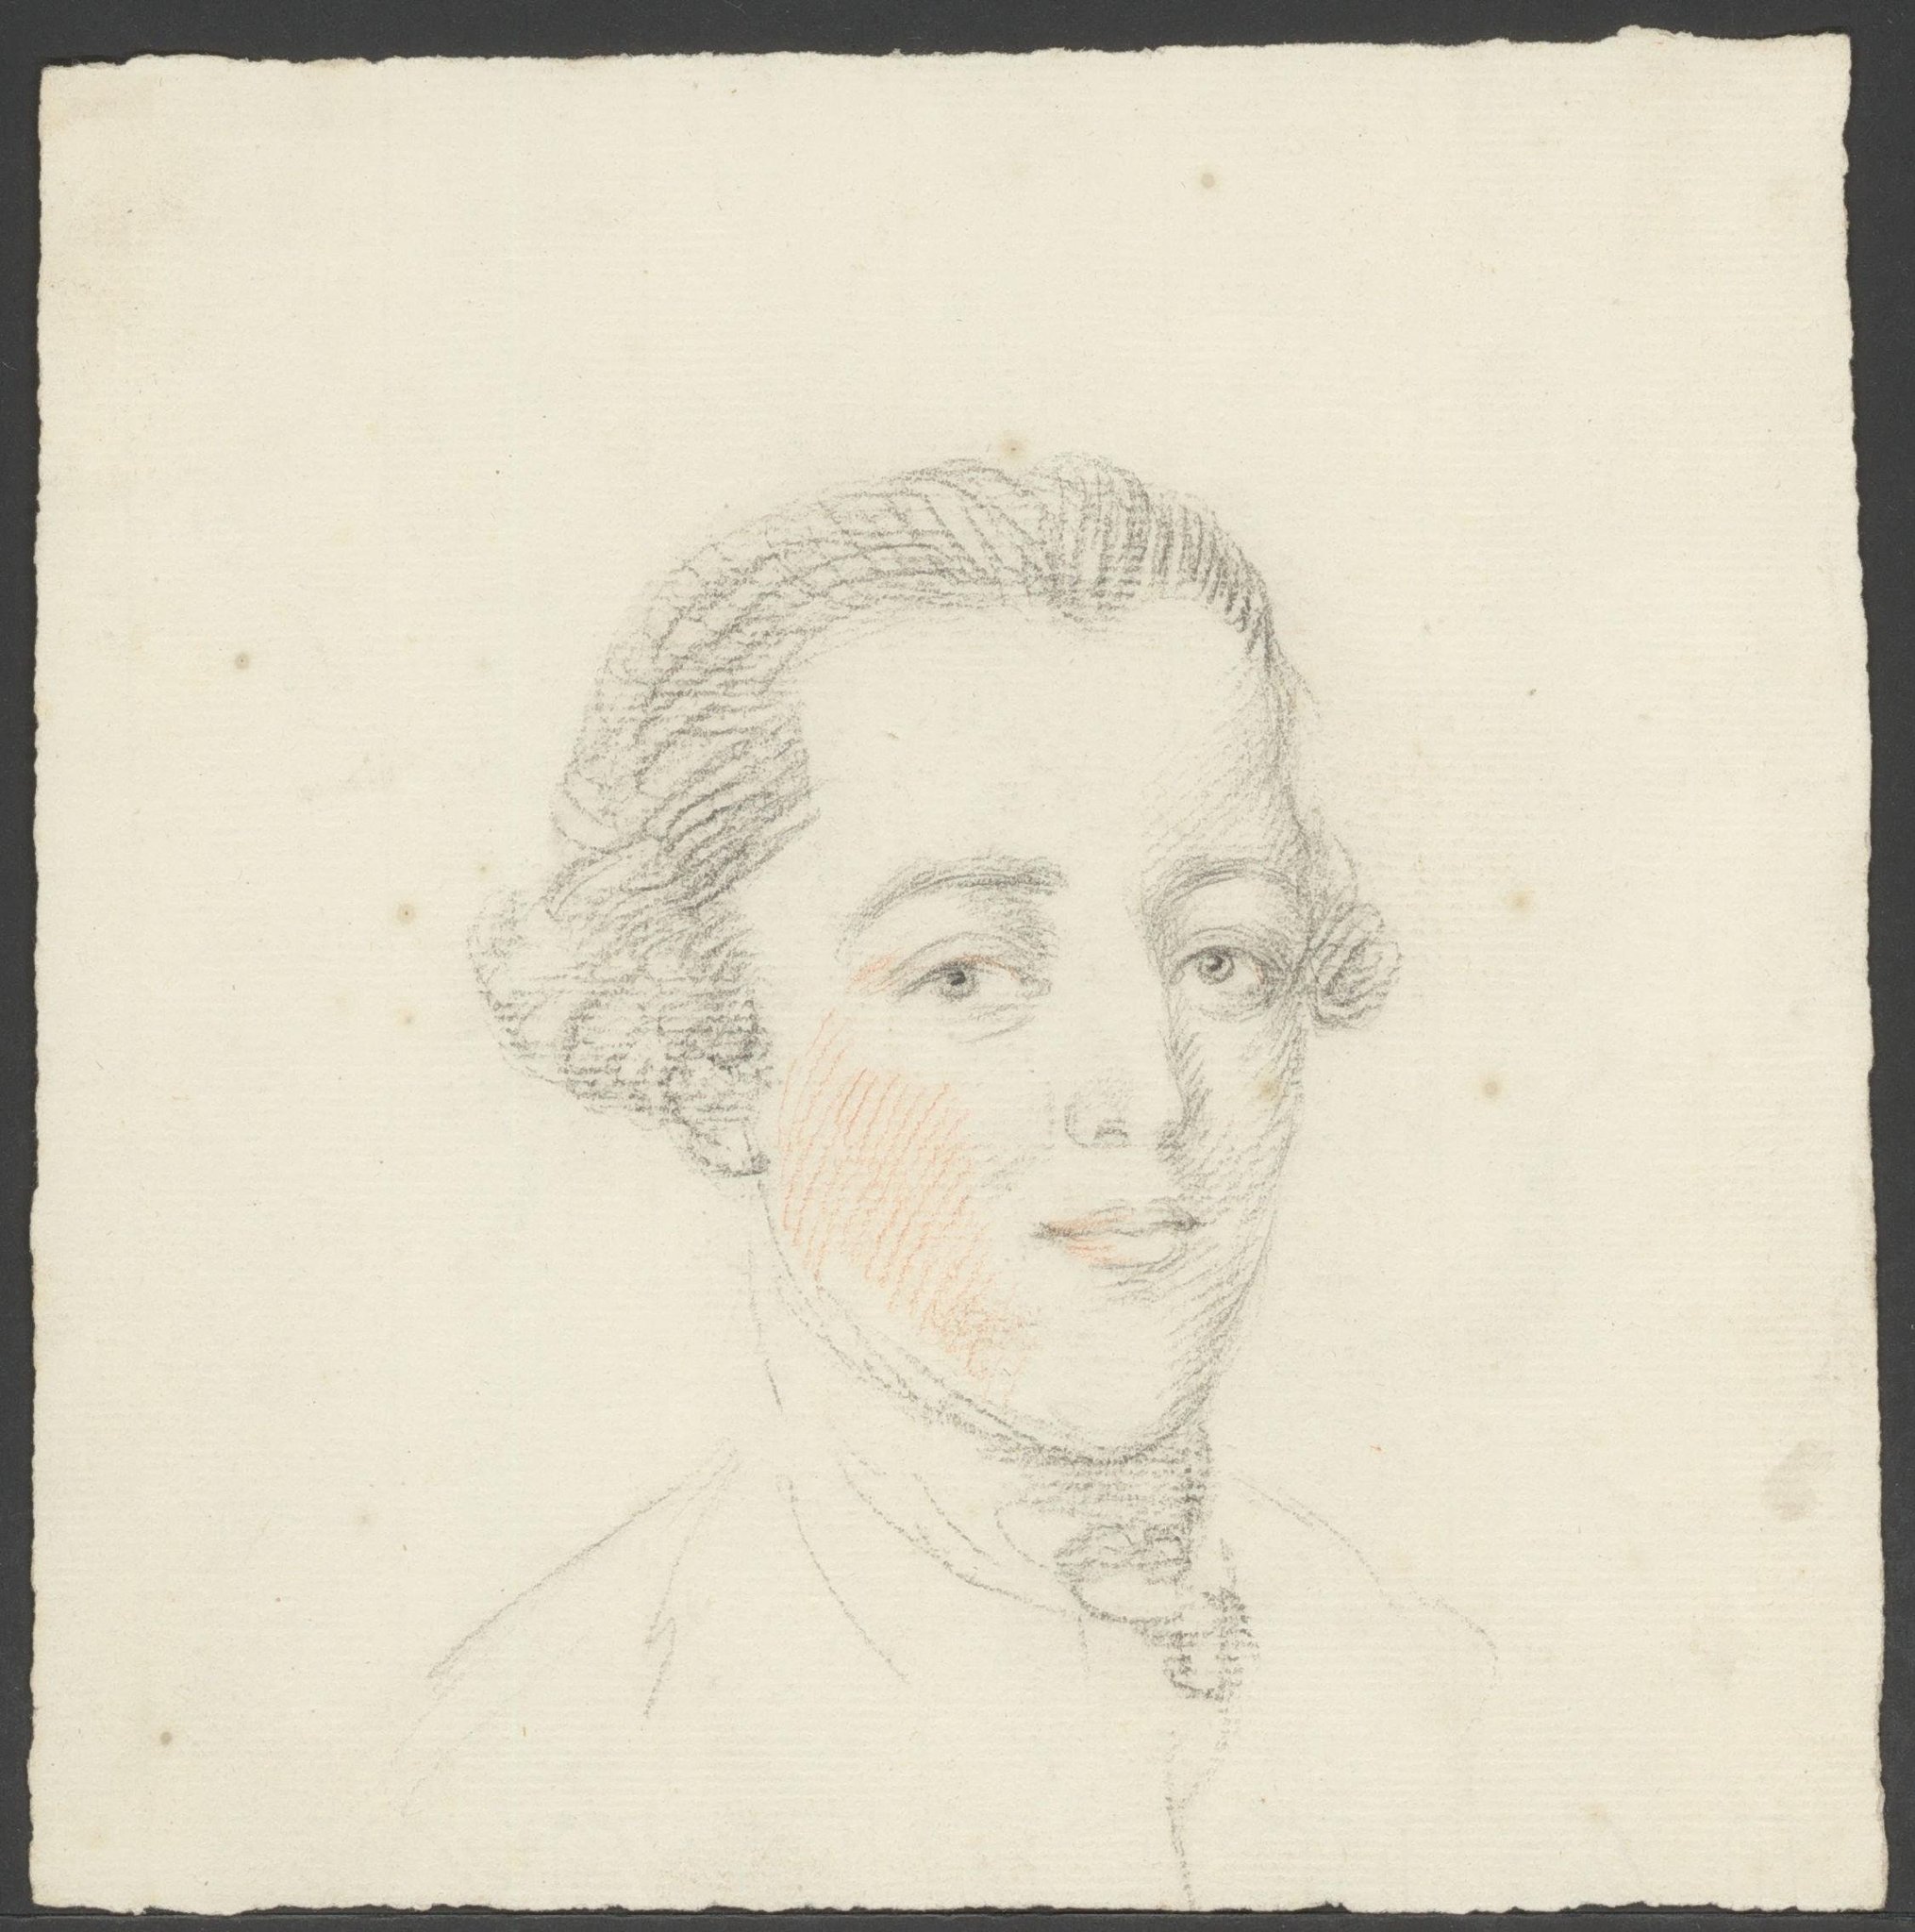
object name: drawing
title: Gezicht van een onbekende man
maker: jean bernard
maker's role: draughtsman, print maker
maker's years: 1765-1833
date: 1775-1833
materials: chalk, paper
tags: face (+ three-quarter view), youth, adolescent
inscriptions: collector's mark: Lugt 1641, stamp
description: Gezicht van een onbekende man. Onderwerpsrubrieken binnen de Atlas Zeden en Gewoonten: Schoone kunsten, Schilderkunst, Tekeningen.